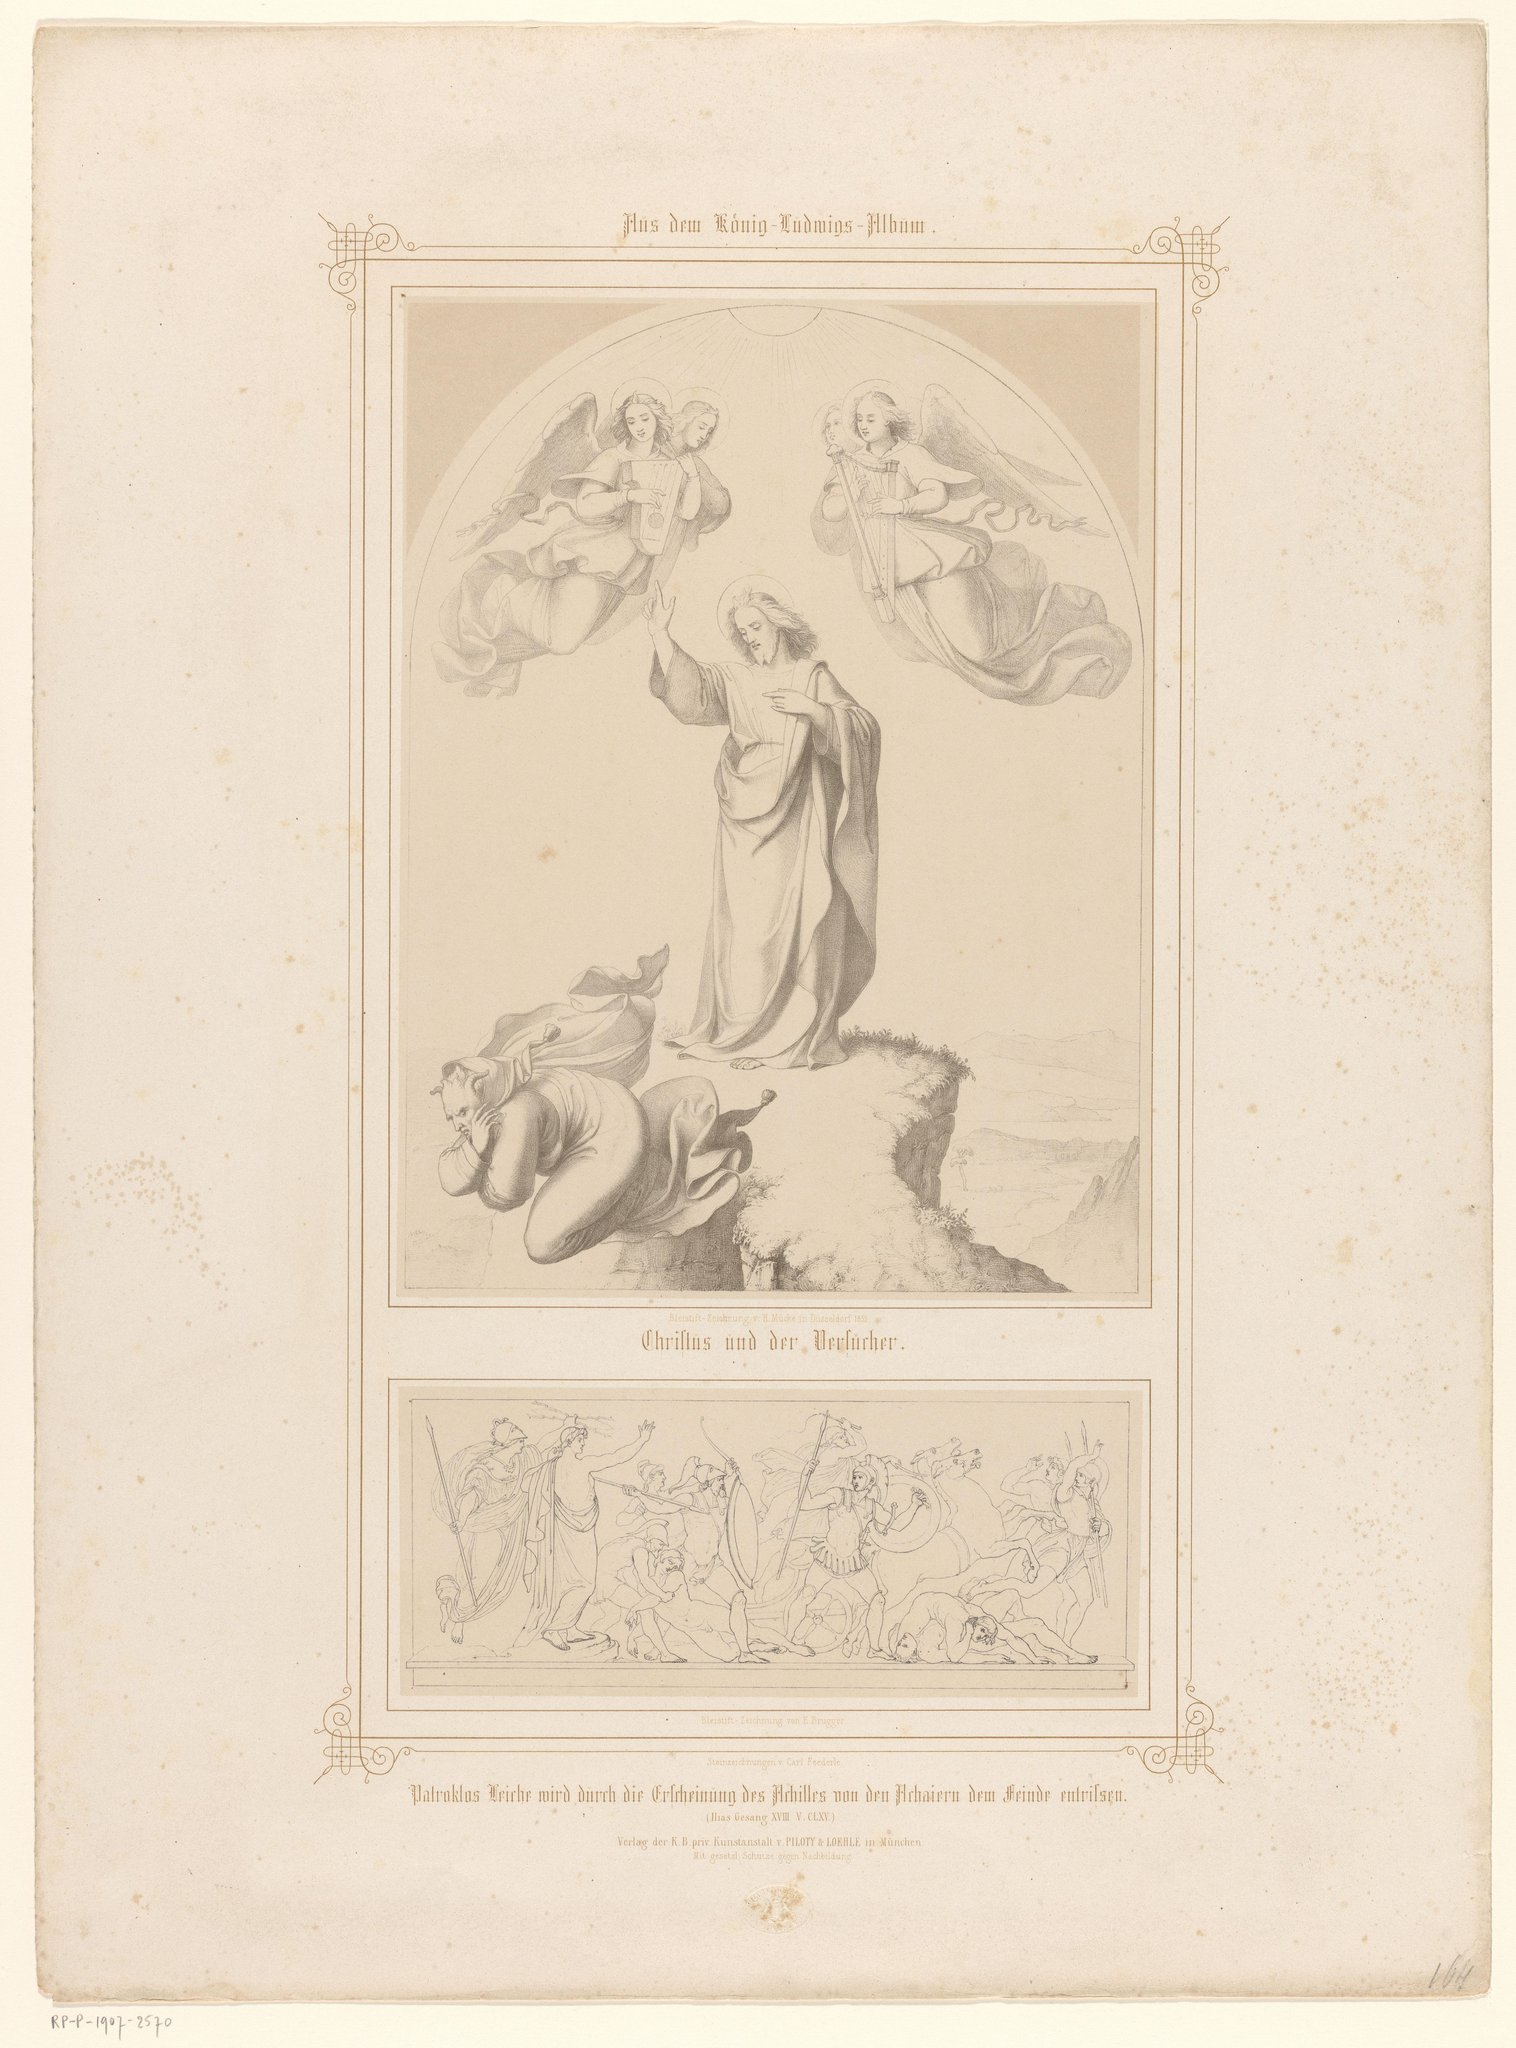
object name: print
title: Album aangeboden aan Lodewijk I van Beieren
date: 1855-1859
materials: paper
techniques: lithograph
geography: munich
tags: death of patroclus: he is killed by hector, christ, sometimes accompanied by guardian angel(s), tempted by satan, who usually appears in human form, battle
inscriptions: collector's mark: Lugt 2228, : ‘Mit gesetzl Schutze gegen Nachbildung’, check stamp: ‘Piloty&Loehle, München’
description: Prent afkomstig uit de serie 'Album Seiner Majestät des Königs Ludwig I. von Bayern', verschenen in verschillende afleveringen. De prenten gaan terug op het album dat Lodewijk I van Beieren op 9 oktober 1850 kreeg overhandigd van verschillende kunstenaars.